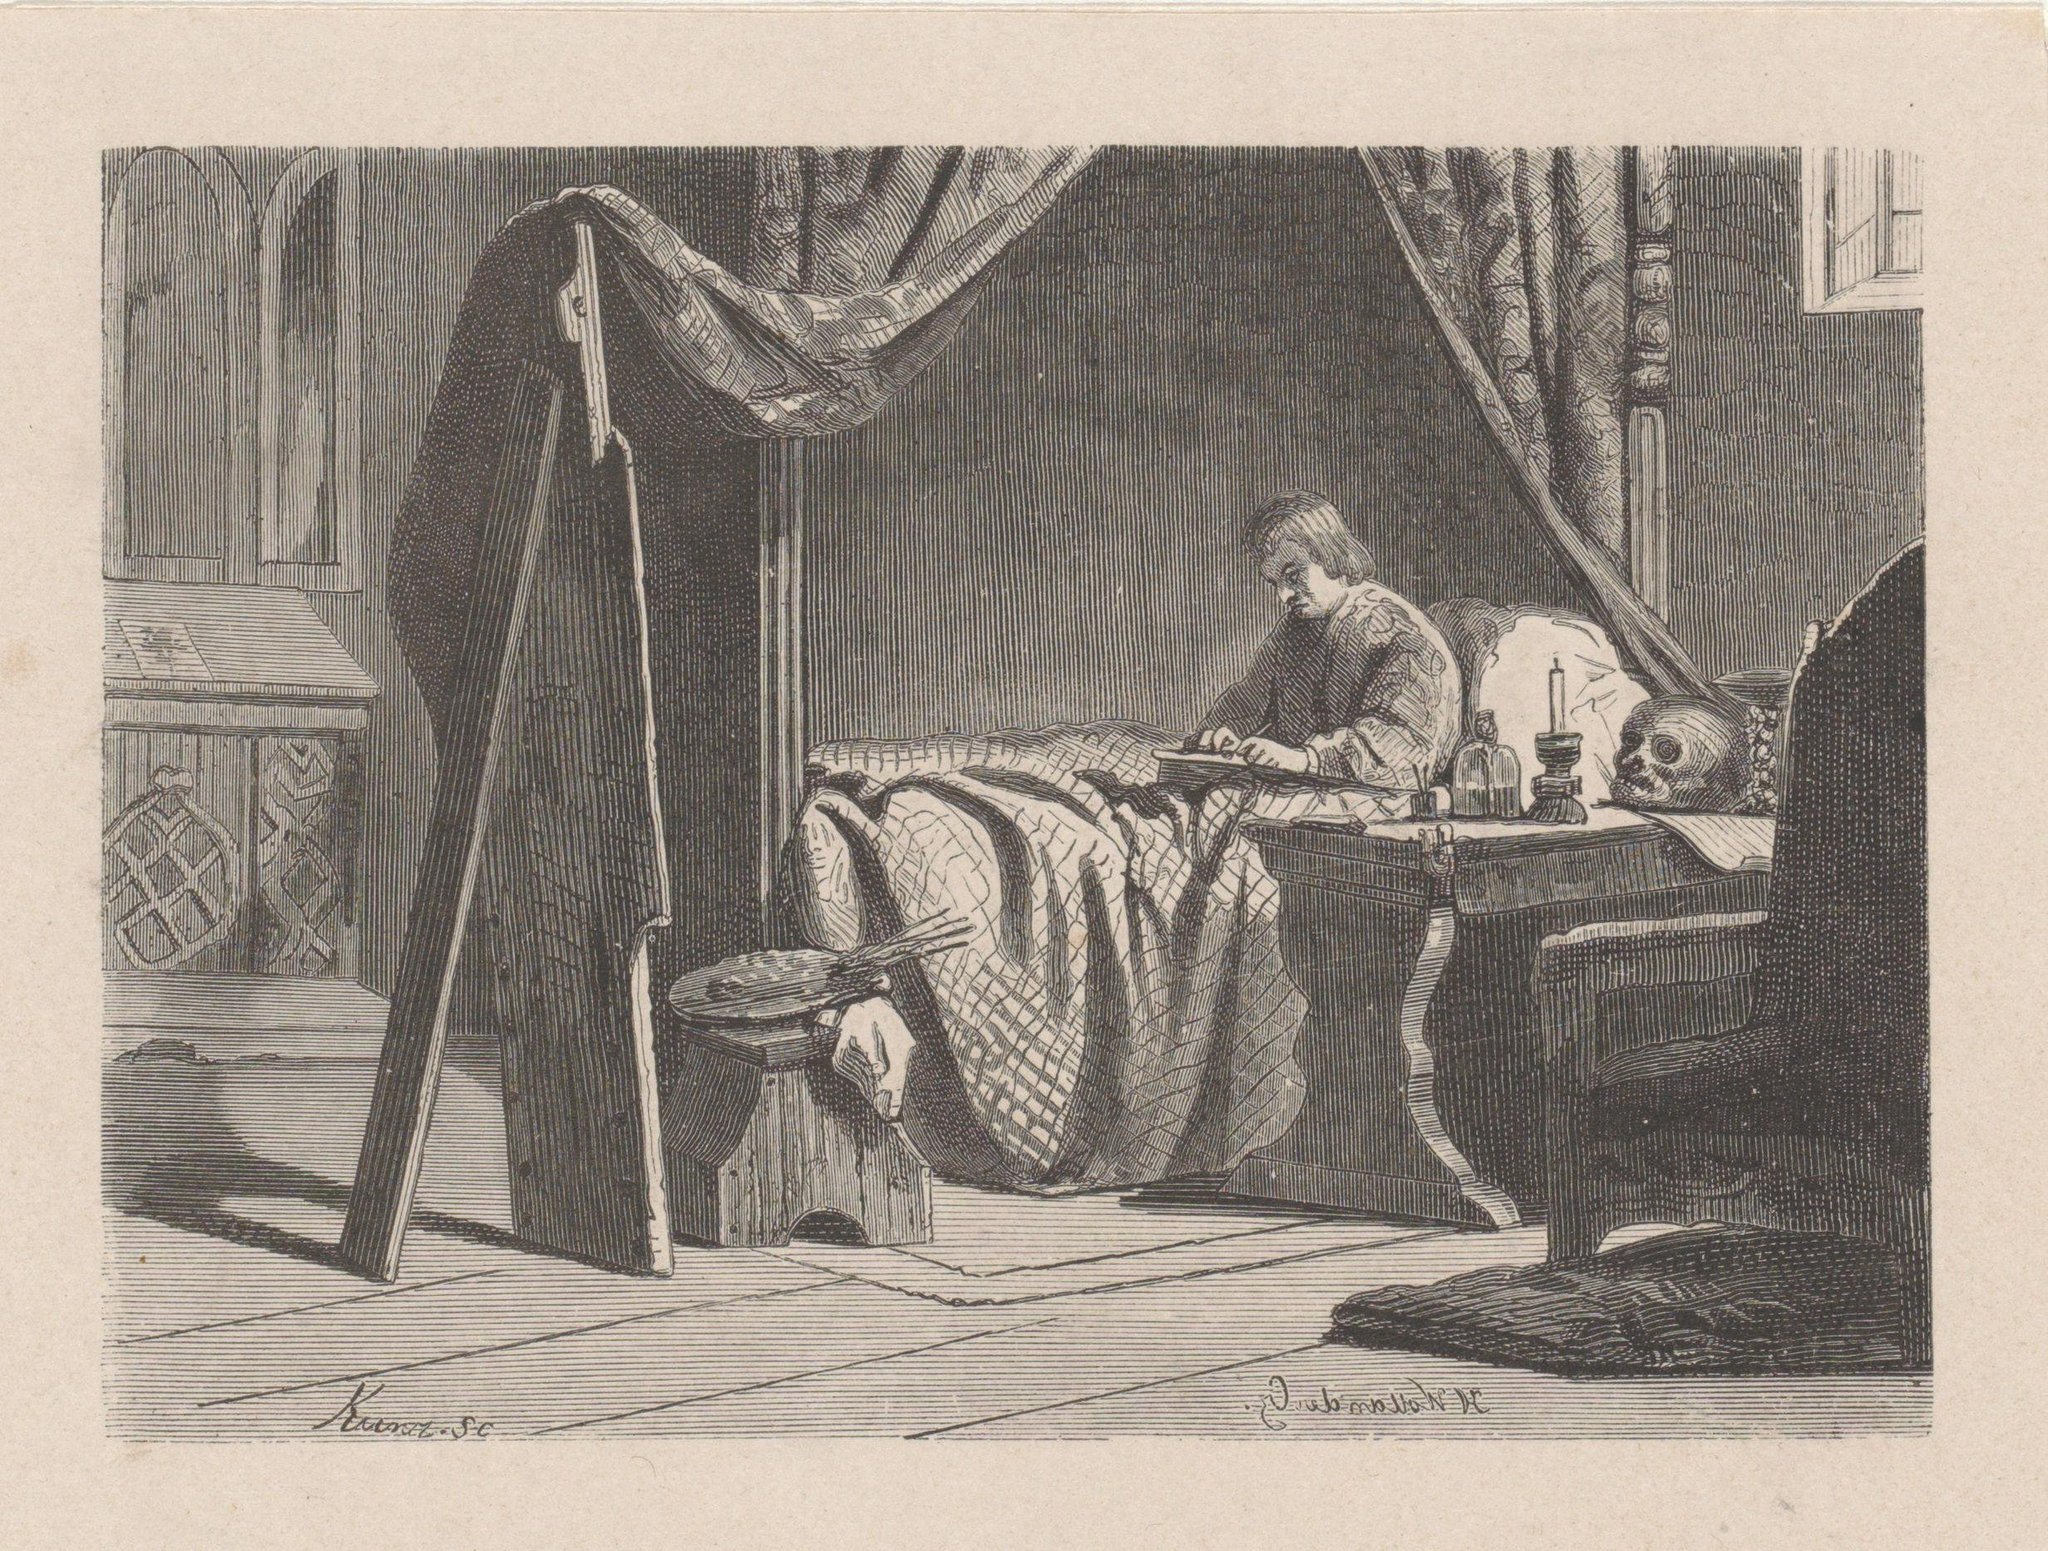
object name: print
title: Schilder in zijn atelier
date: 1835-1925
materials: paper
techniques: engraving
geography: netherlands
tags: (human) skull, workshop, studio ~ painter, candle, bed, easel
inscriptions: collector's mark: Lugt 2228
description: Een schilder zit rechtop in bed en schrijft of tekent in een boek. Voor hem staat zijn schildersezel. Op de tafel naast hem ligt een schedel en brandt een kaars.